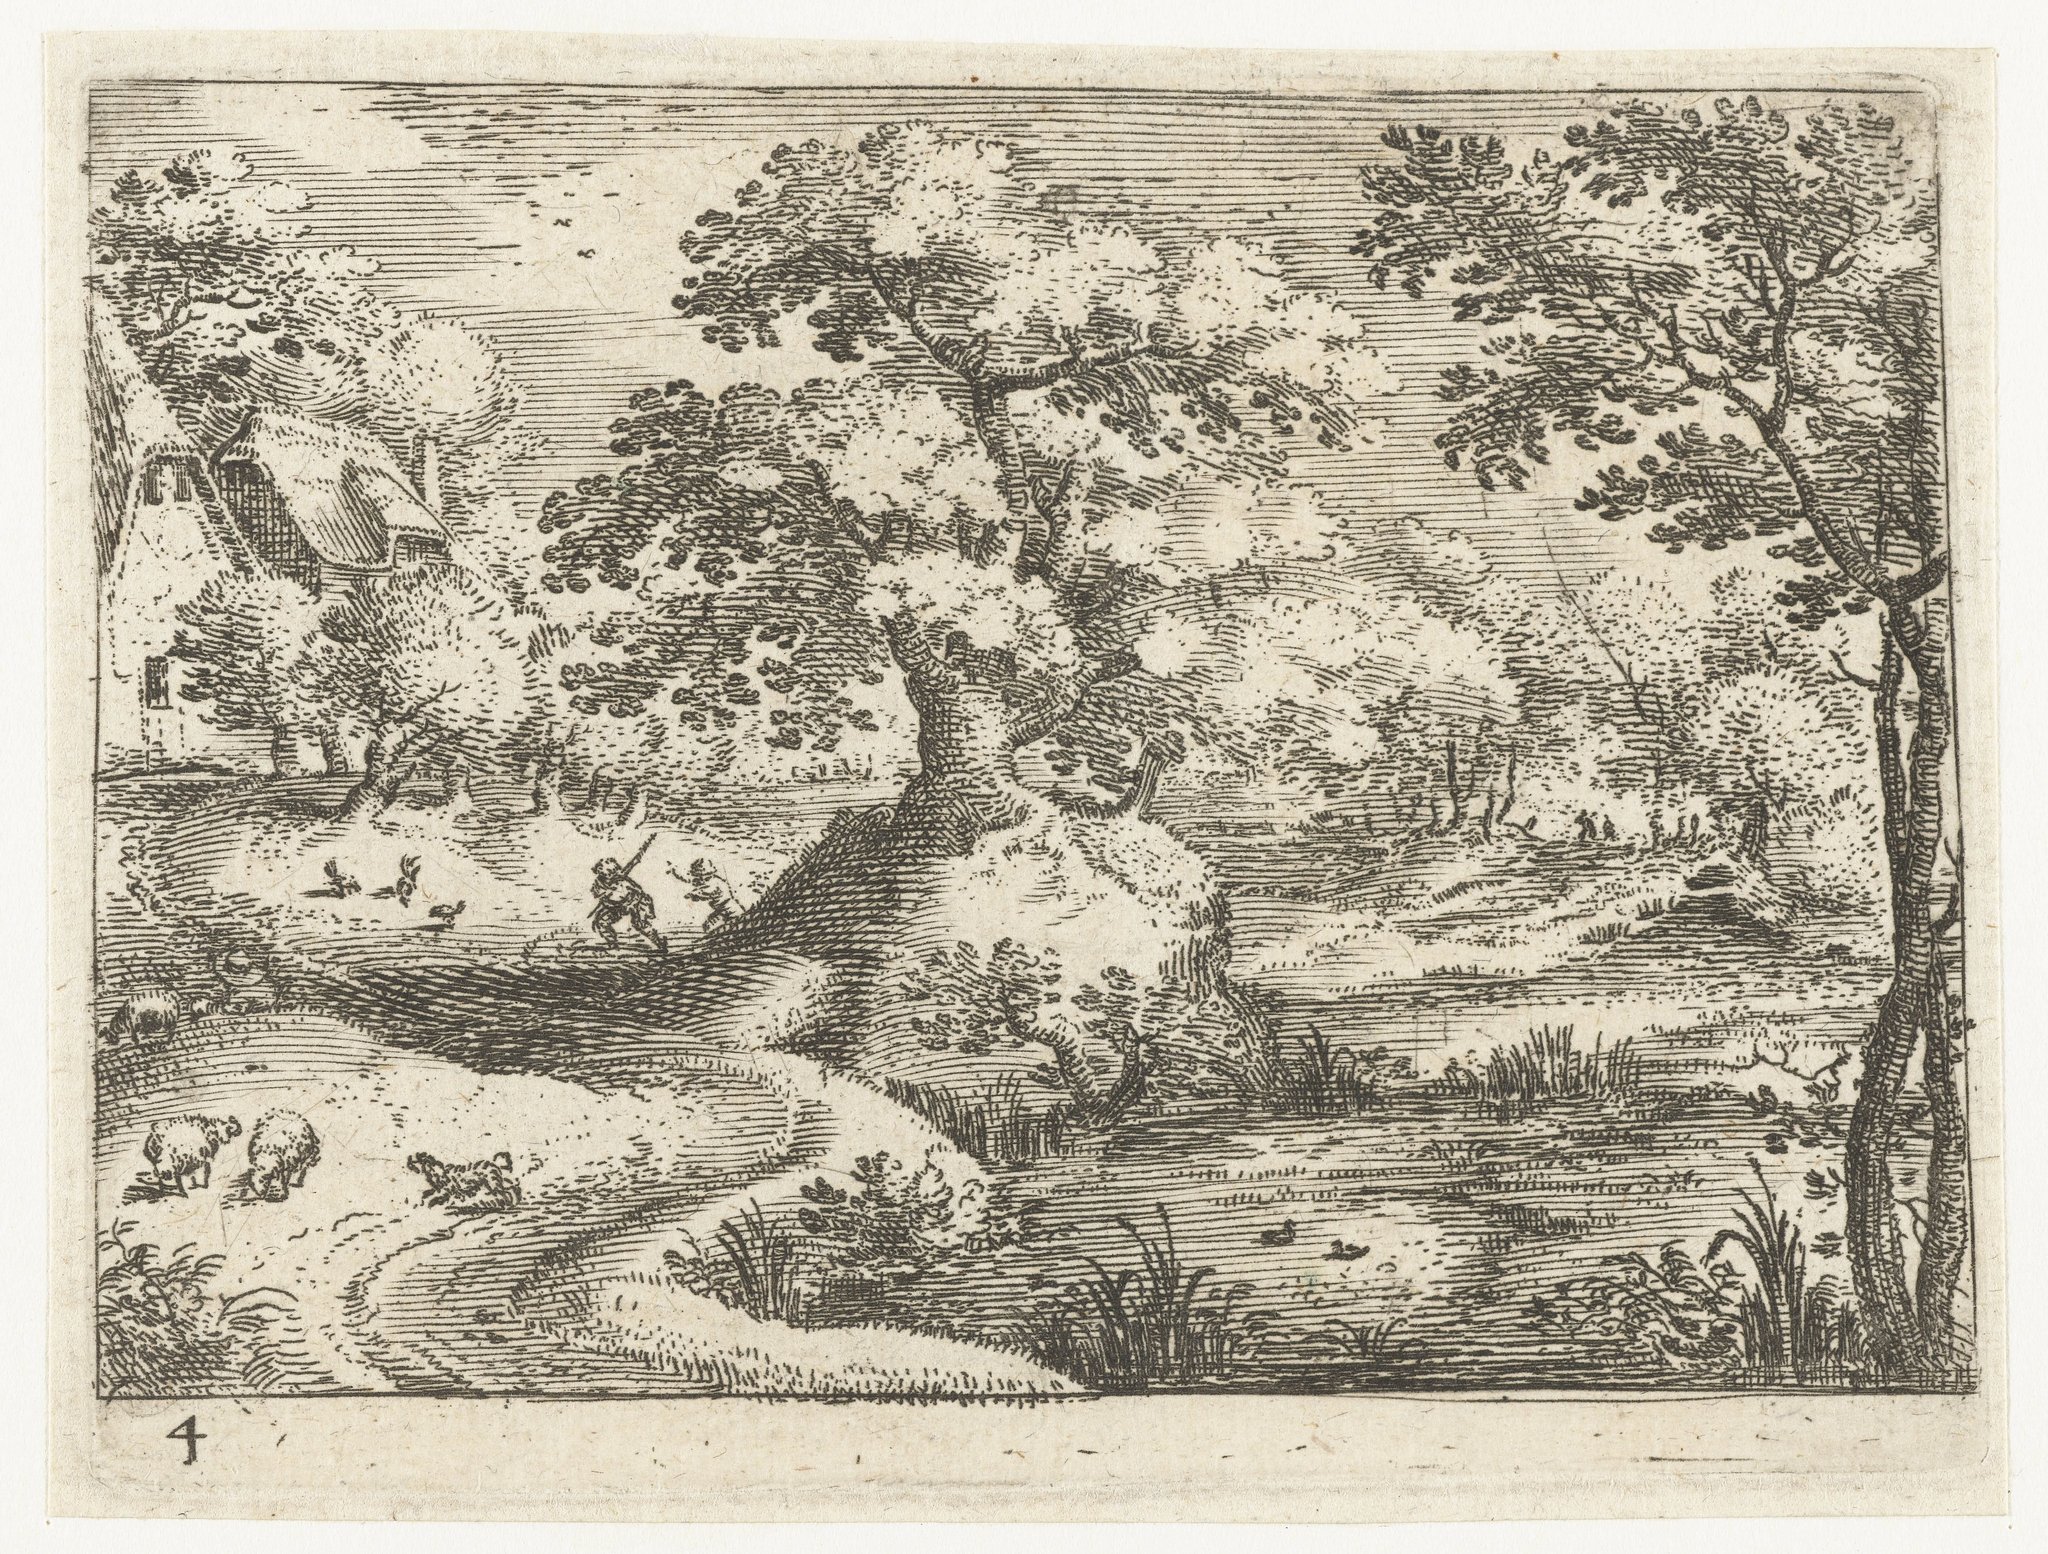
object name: print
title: Zes landschappen met reizigers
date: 1584-1603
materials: paper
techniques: engraving, etching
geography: netherlands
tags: landscapes in the temperate zone, 'en route', traveller under way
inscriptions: collector's mark: Lugt 2228a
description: In een bomenrijk landschap lopen twee reizigers met een hond langs een moeras naar twee huizen. Deze prent is onderdeel van een serie van zes landschappen met reizigers.